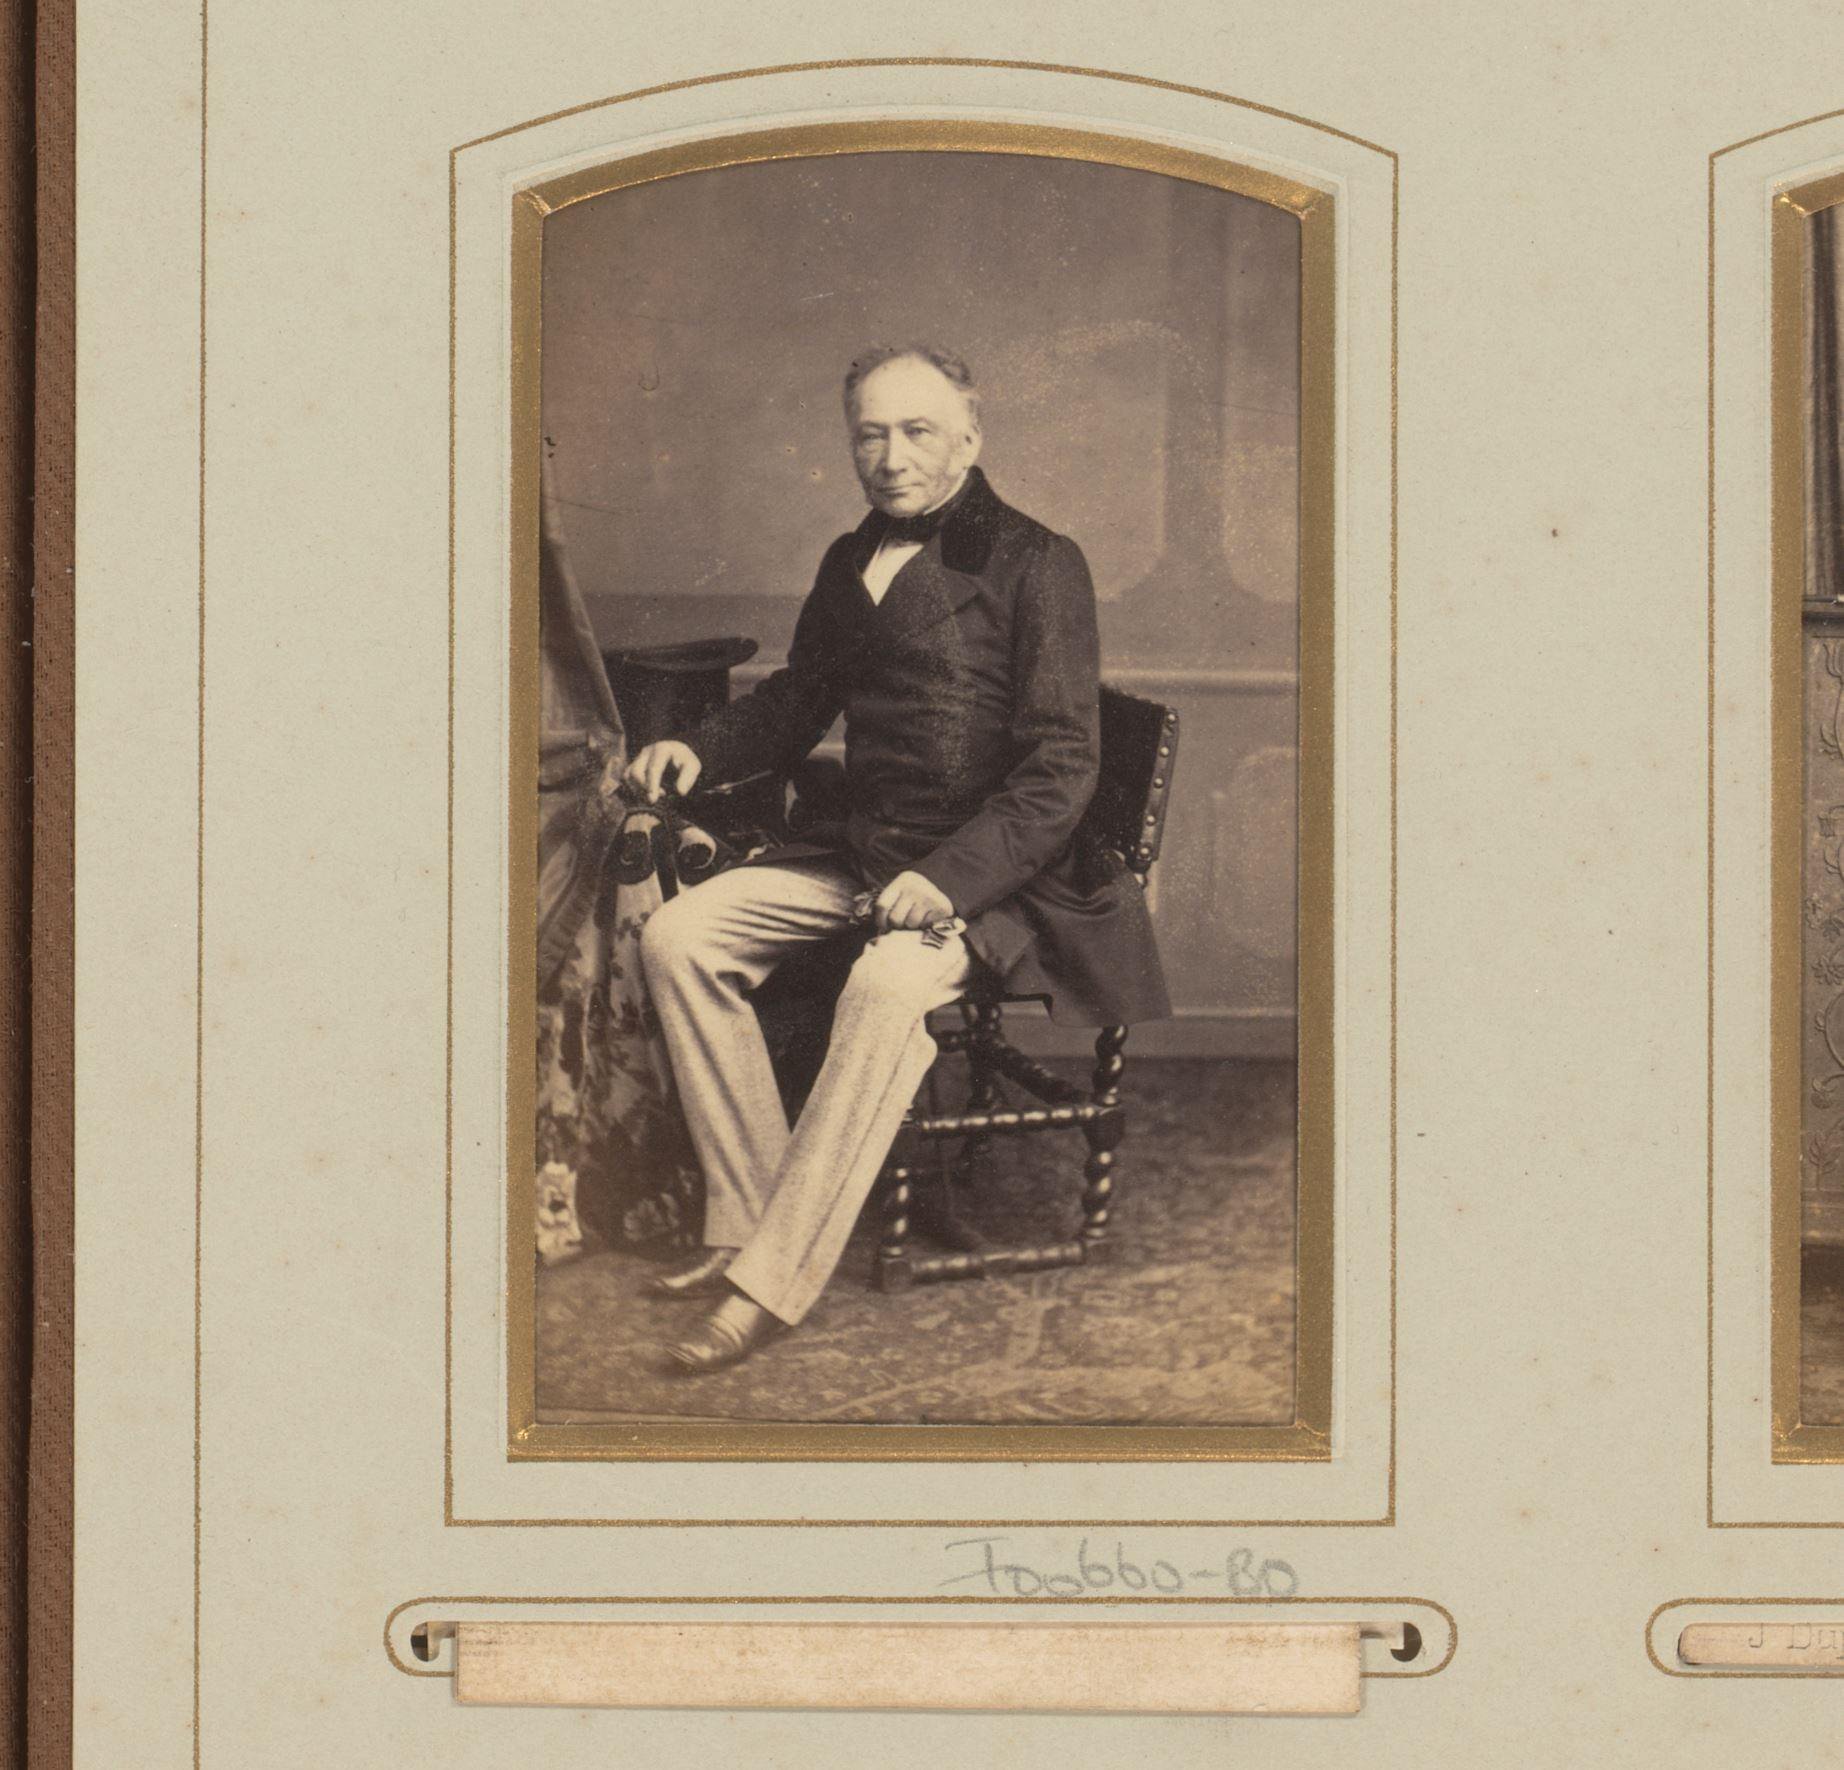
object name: photograph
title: Portret van een zittende man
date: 1860-1894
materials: cardboard, photographic support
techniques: albumen print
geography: brussels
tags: sitting figure, historical persons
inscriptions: inscription: ‘ATELIER DE PHOTOGRAPHIE./ GHÉMAR FRÈRES./ PHOTOGRAPHES DU ROI,/ 27, rue de l'Ecuyer,/ entrée par la porte cochère/ BRUXELLES.’